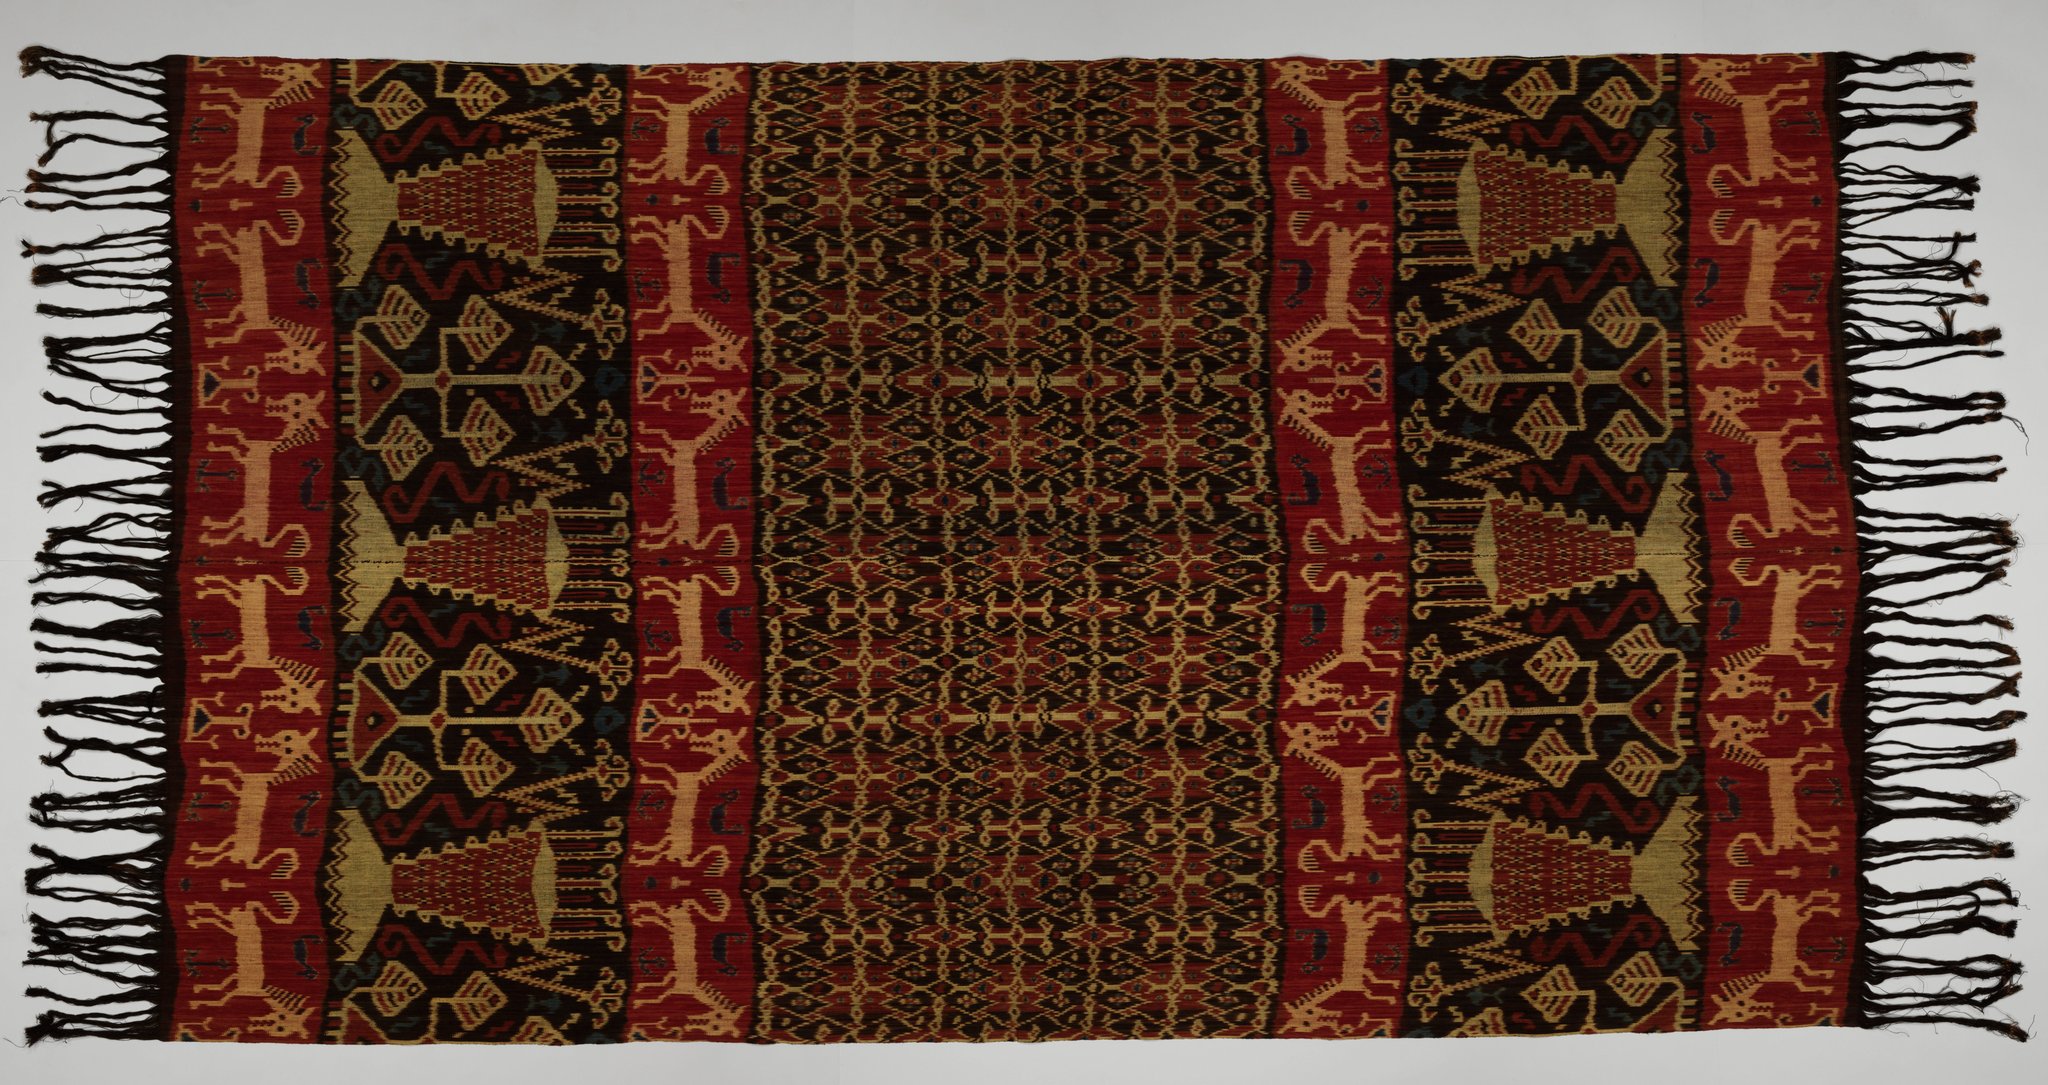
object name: omslagdoek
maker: Anonymous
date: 1900-1949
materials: cotton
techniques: weave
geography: soemba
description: Omslagdoek met aan de onderkant een rij met paarden, symbolen van de bovenwereld.